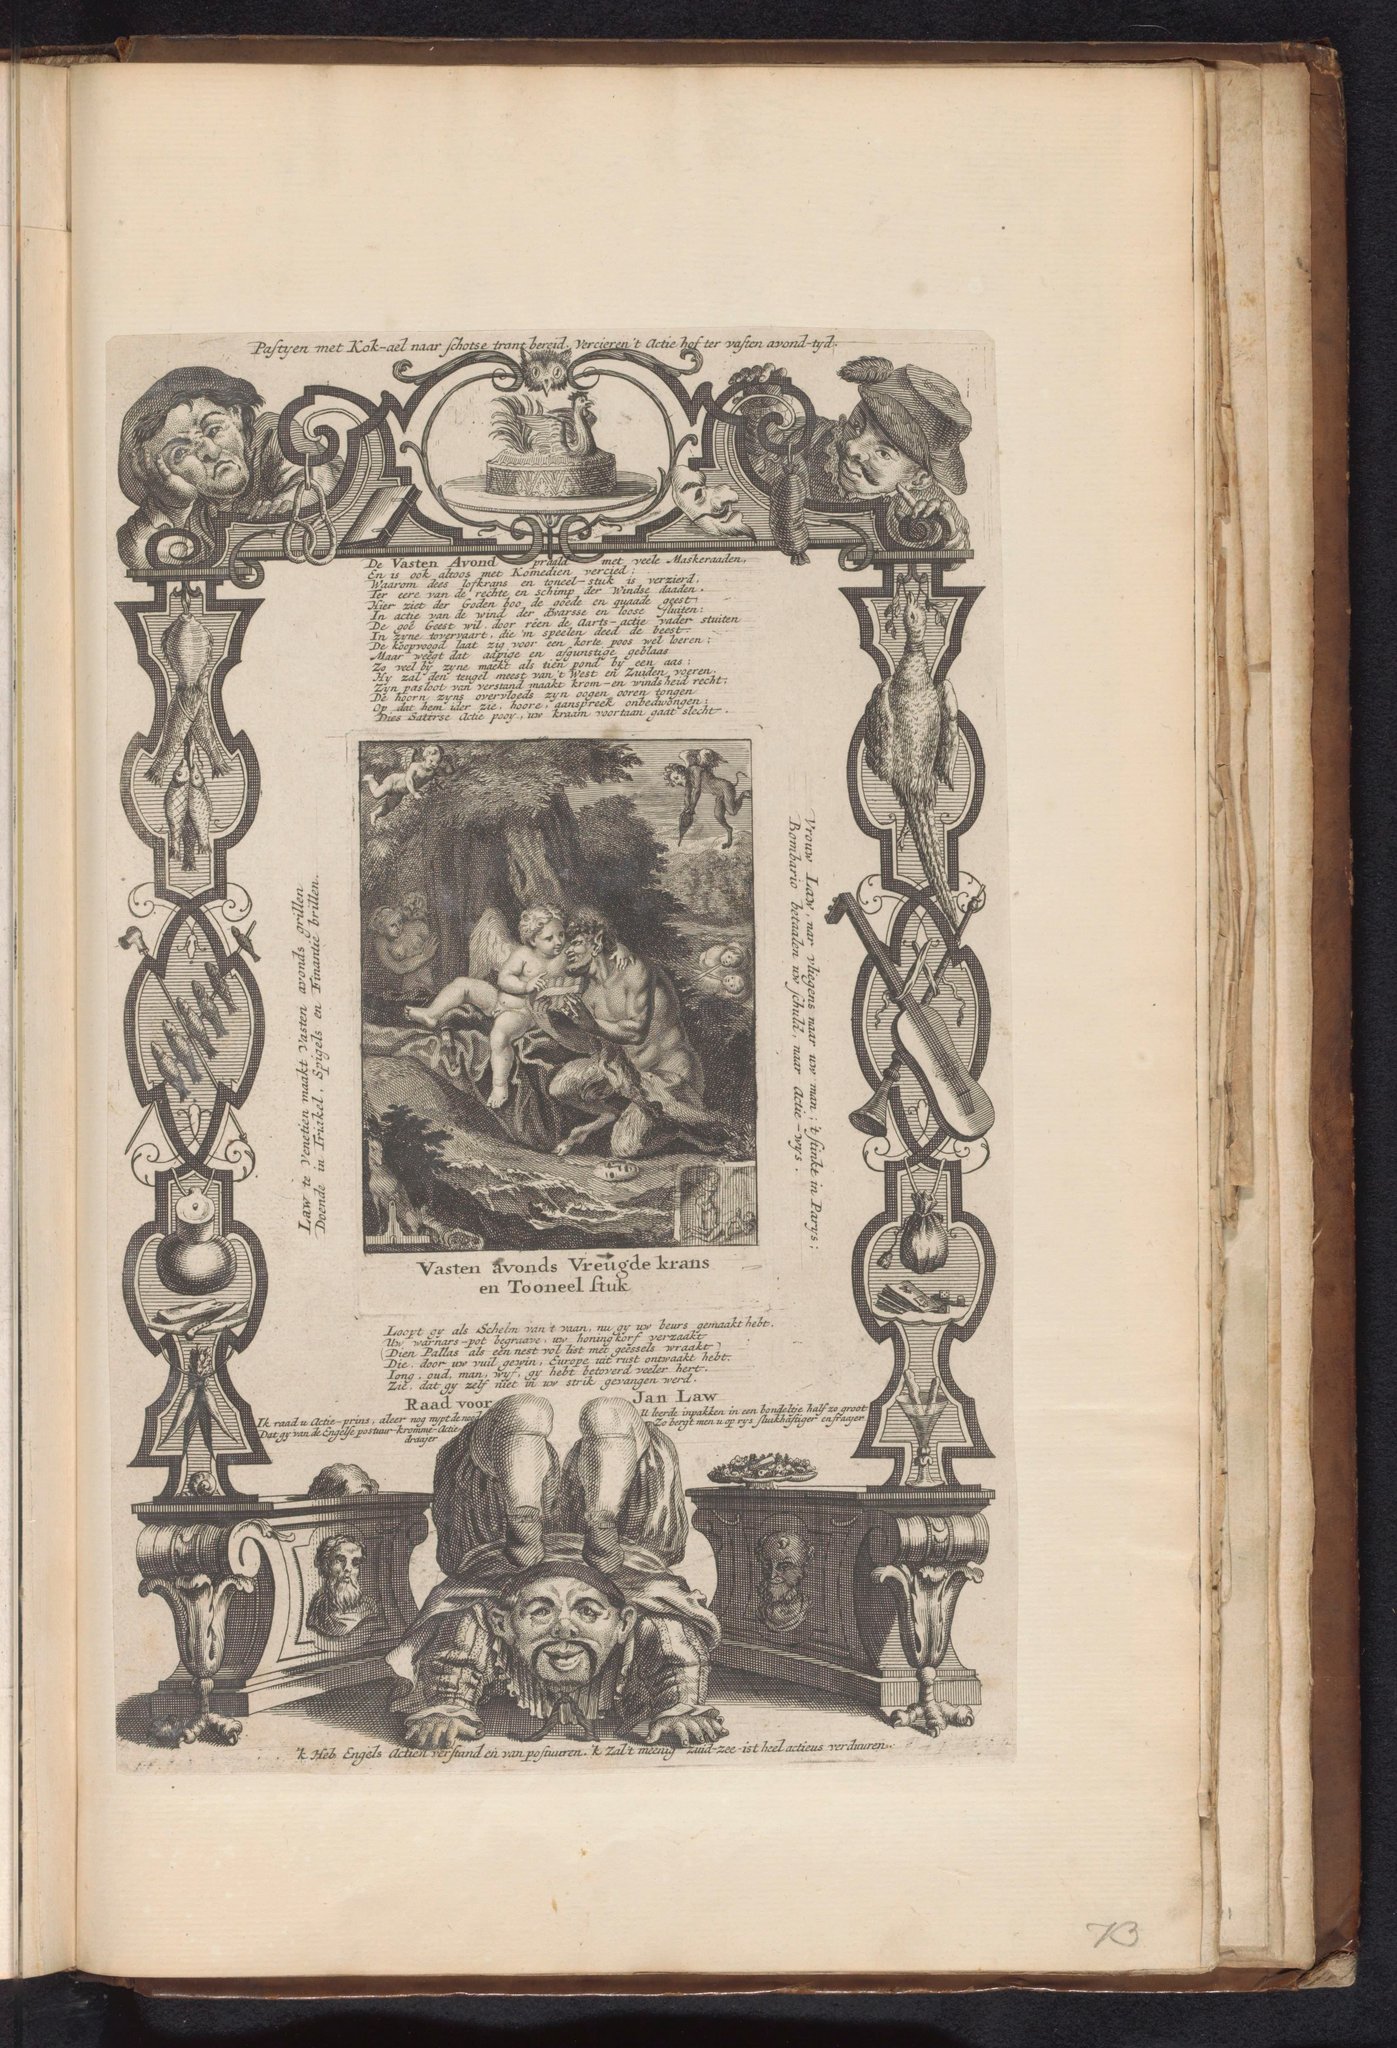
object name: print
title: Vastenavond vreugdekrans en toneelstuk, 1720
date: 1720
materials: paper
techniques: engraving, etching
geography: amsterdam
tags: most important deeds: marsyas and the flute, little people, shrove thursday, 'jeudi gras'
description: Vastenavond vreugdekrans en toneelstuk. Centrale voorstelling waarin Cupido Pan (of Marsyas) de fluit leert bespelen, op de achtergrond een naakte nimf. Hier dient de voorstelling geïnterpreteerd te worden als John Law die zijn masker heeft afgedaan en als de god van de windhandel door de goede geest wordt aangeraden van de windhandel af te zien. De nimf moet dan mevrouw Law voorstellen. In een apart gedrukte omlijsting met kleine mensen, muziekinstrumenten en etenswaren die verwijzen naar Vastenavond. Met verschillende versjes. Prent (uitgeknipt en ingeplakt) in de gebonden eerste uitgave (304 B 11) van Het Groote Tafereel der Dwaasheid met spotprenten op de Windhandel of Actiehandel van 1720.